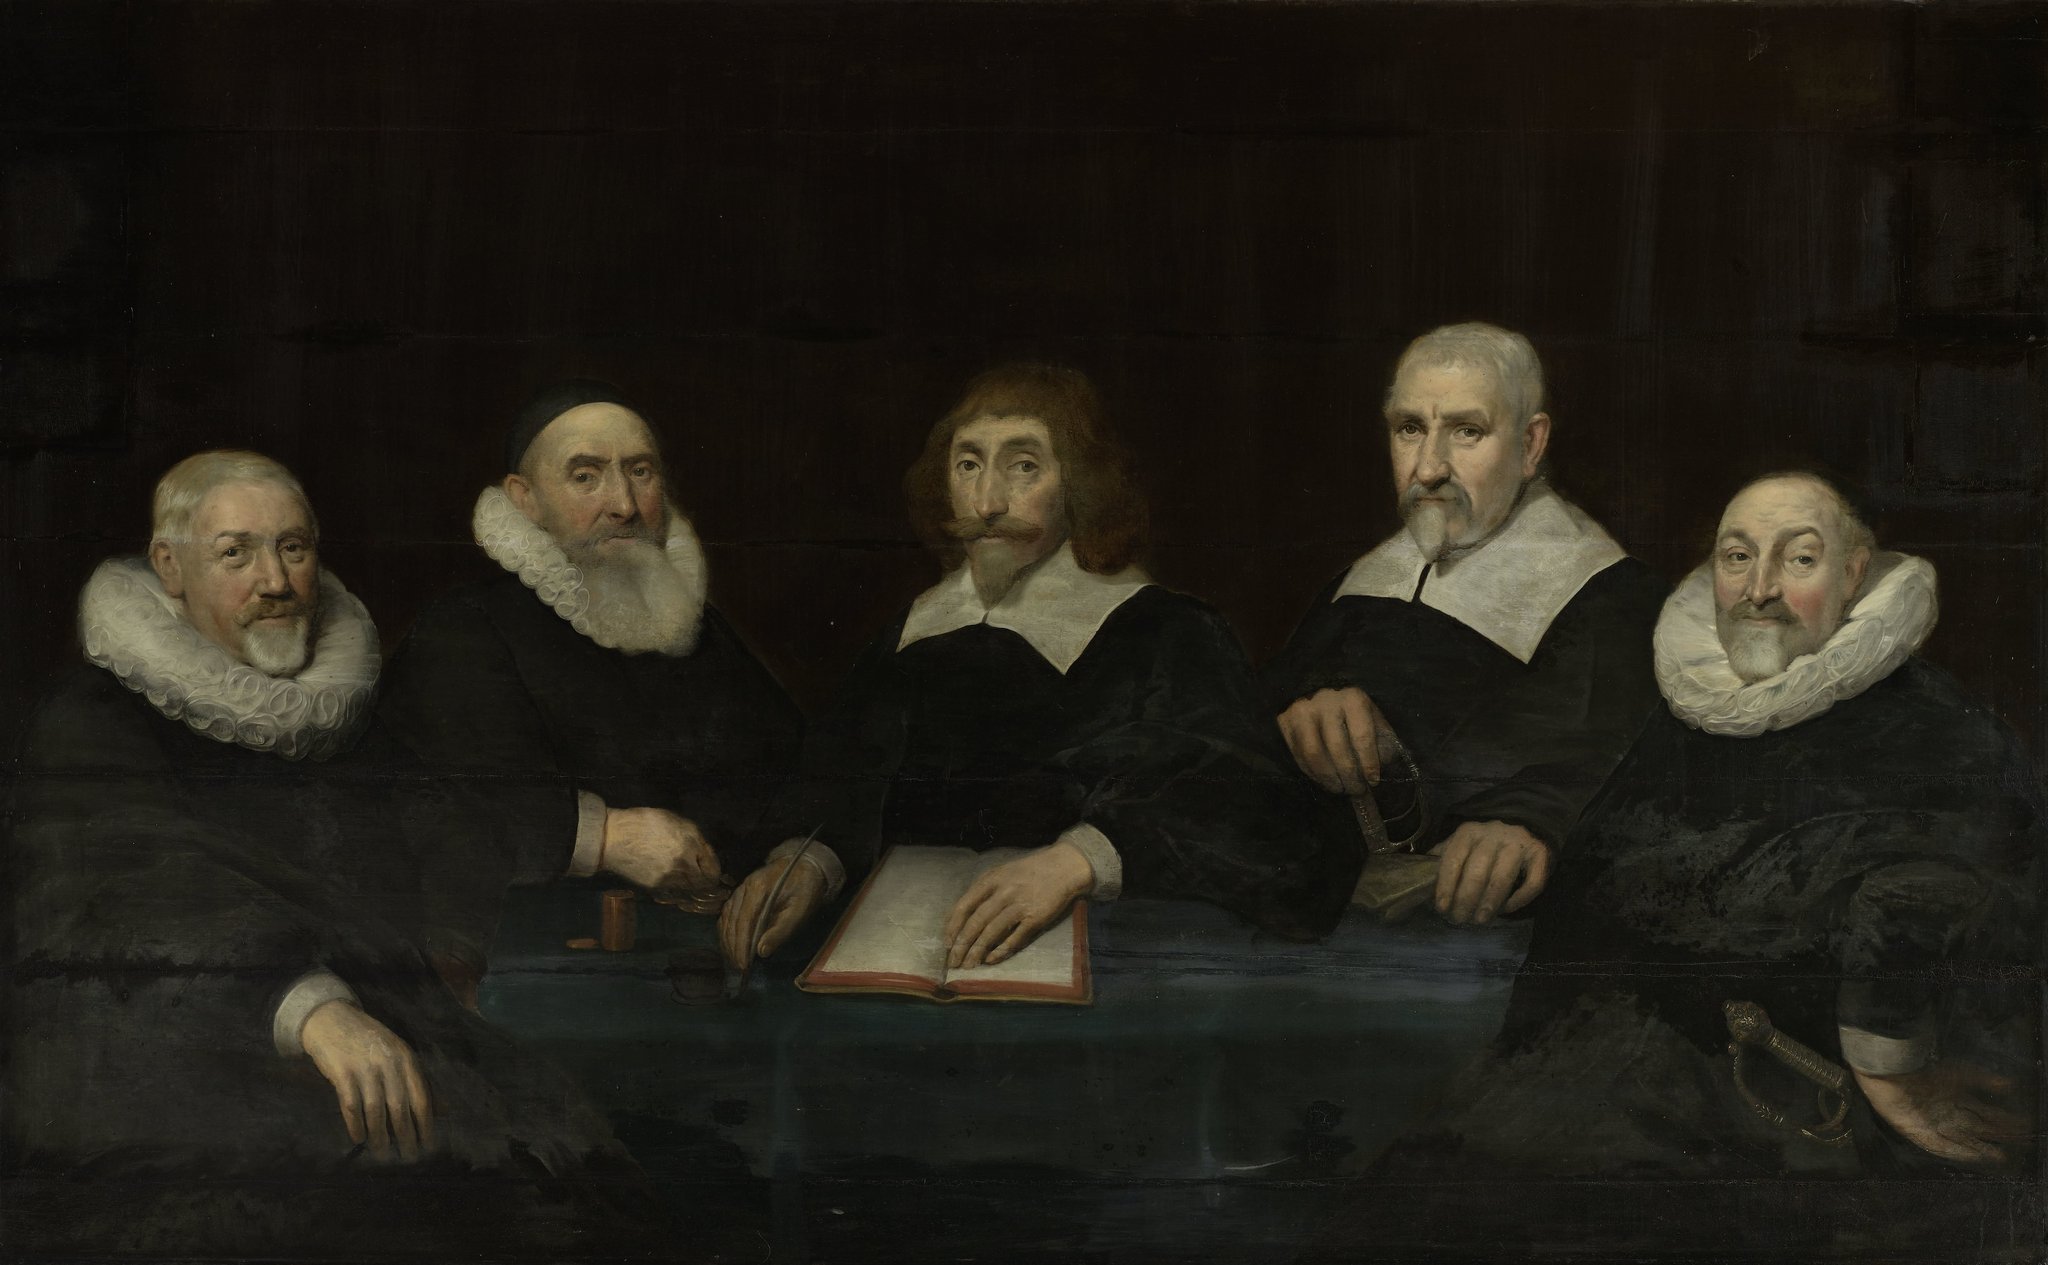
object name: painting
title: Portrait of the Regents of the House of Correction in Middelburg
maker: allaert van loeninga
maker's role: painter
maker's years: 1595-1650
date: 1643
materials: oil, panel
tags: tuchthuis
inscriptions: signature and date, upper right: ‘A. Loening[.] / F. Aº : 164[.]’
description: Groepsportret van de regenten van het Tuchthuis te Middelburg, 1643. Vijf heren, zittend rond een tafel: Jacques van Neulingem (schepen van Middelburg), Sijmen van Trijst (kiesheer van Middelburg), Guillaume de Wolff (majoor), Cornelis Erckenbout en Matthias Molanus. De middelste man heeft een boek voor hem open op tafel liggend en een pen in de rechterhand. De tweede man van links telt met de rechterhand geldstukken. De tweede man van rechts heeft zijn handen op het gevest van zijn sabel.